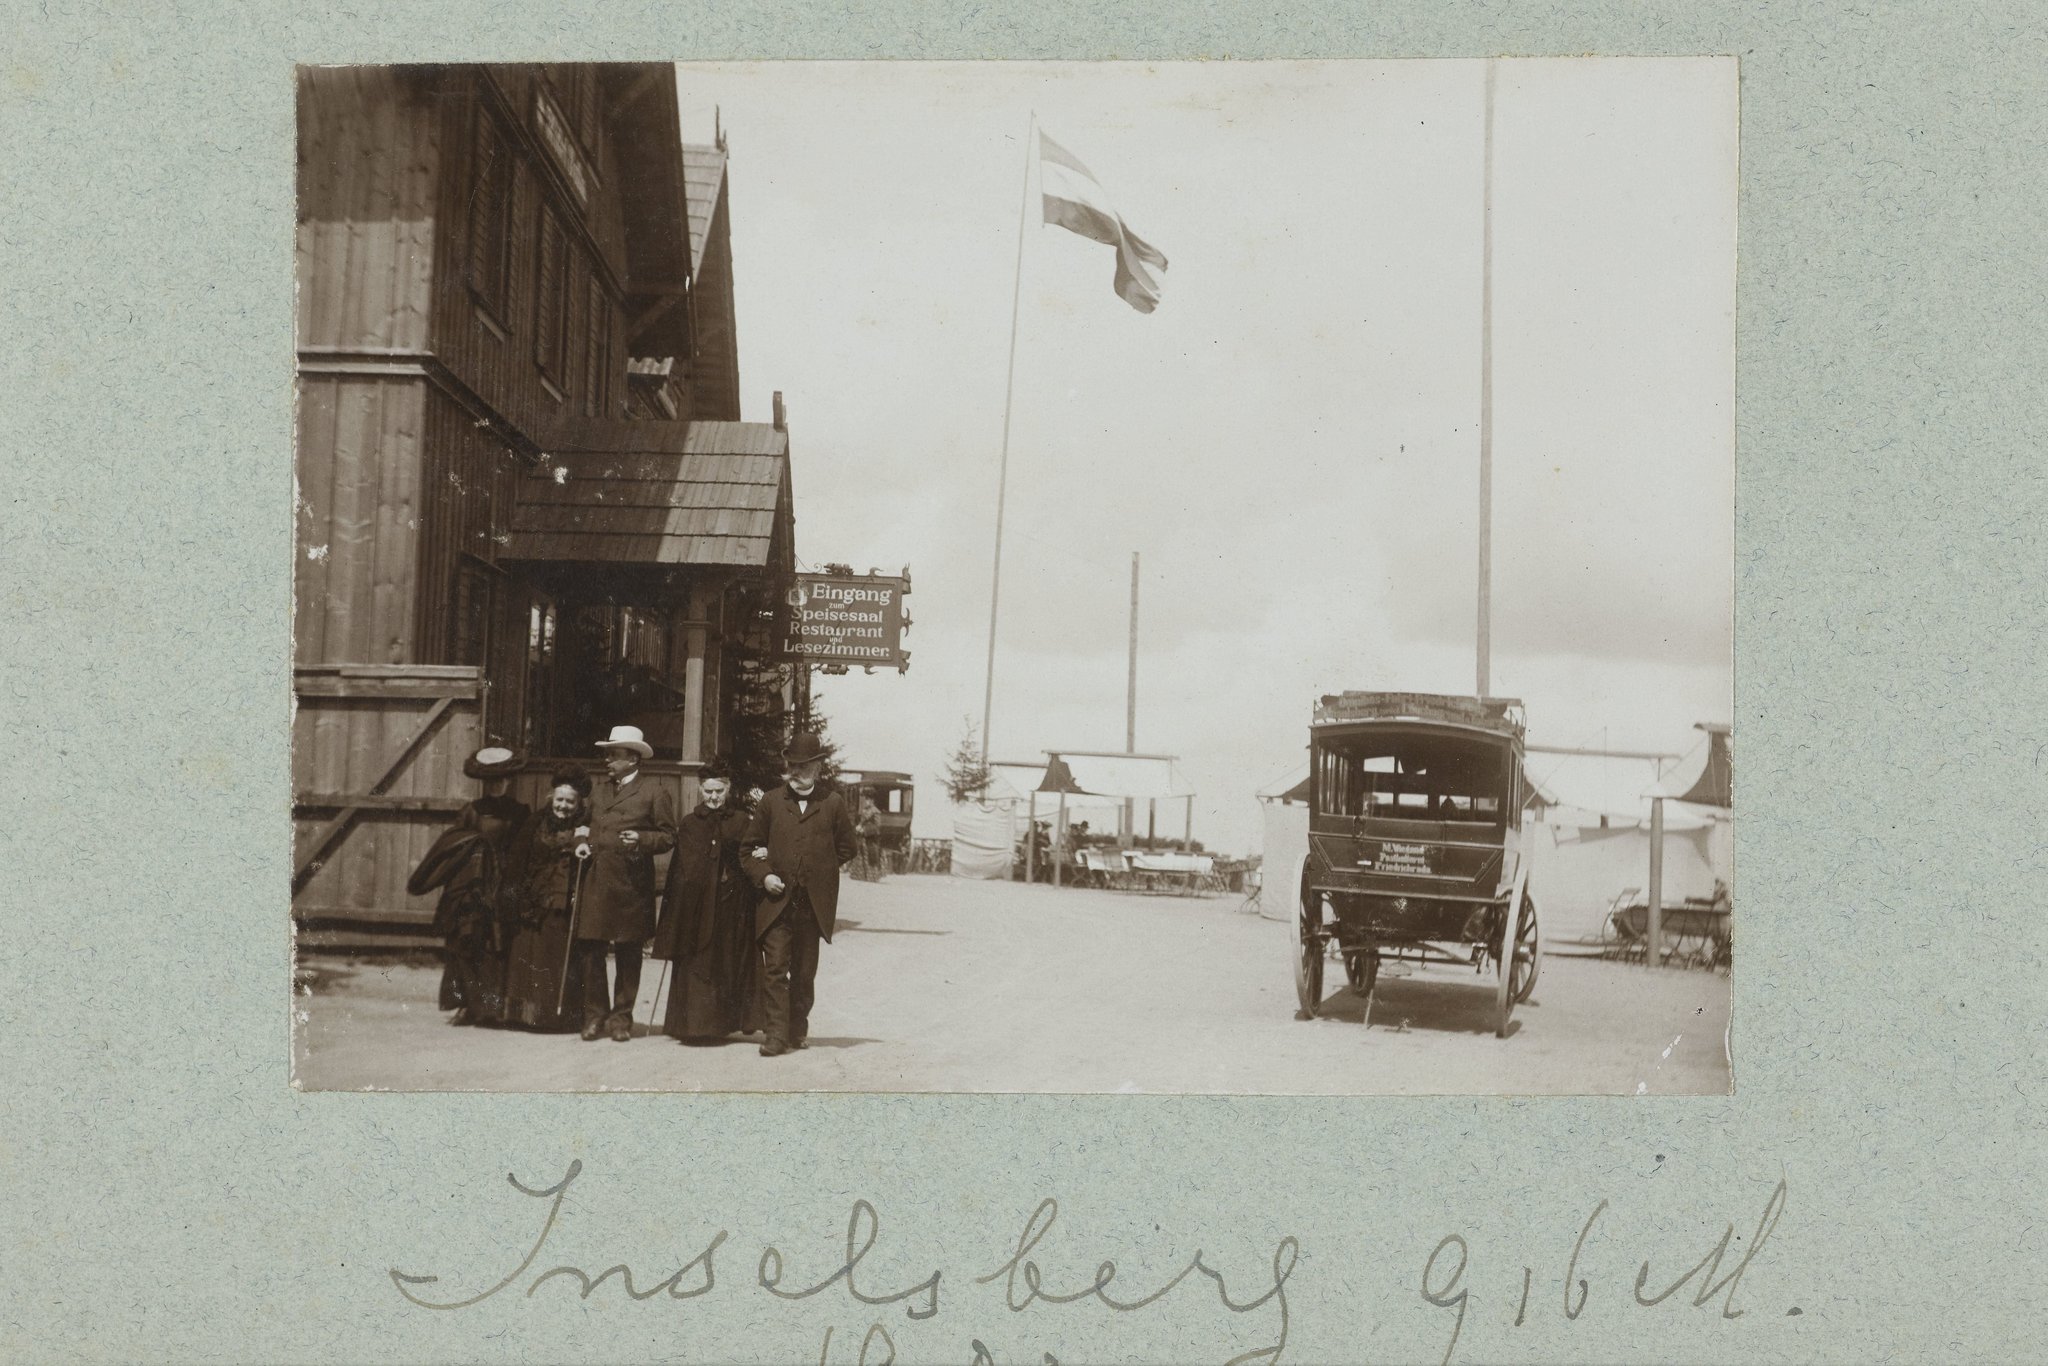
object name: photograph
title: Inselsberg (...) 1903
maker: frits freerks fontein fz.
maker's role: fotograaf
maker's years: 1882-1928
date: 1903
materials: cardboard, paper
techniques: gelatin silver print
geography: netherlands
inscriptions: caption: ‘Inselsberg ... 1903’